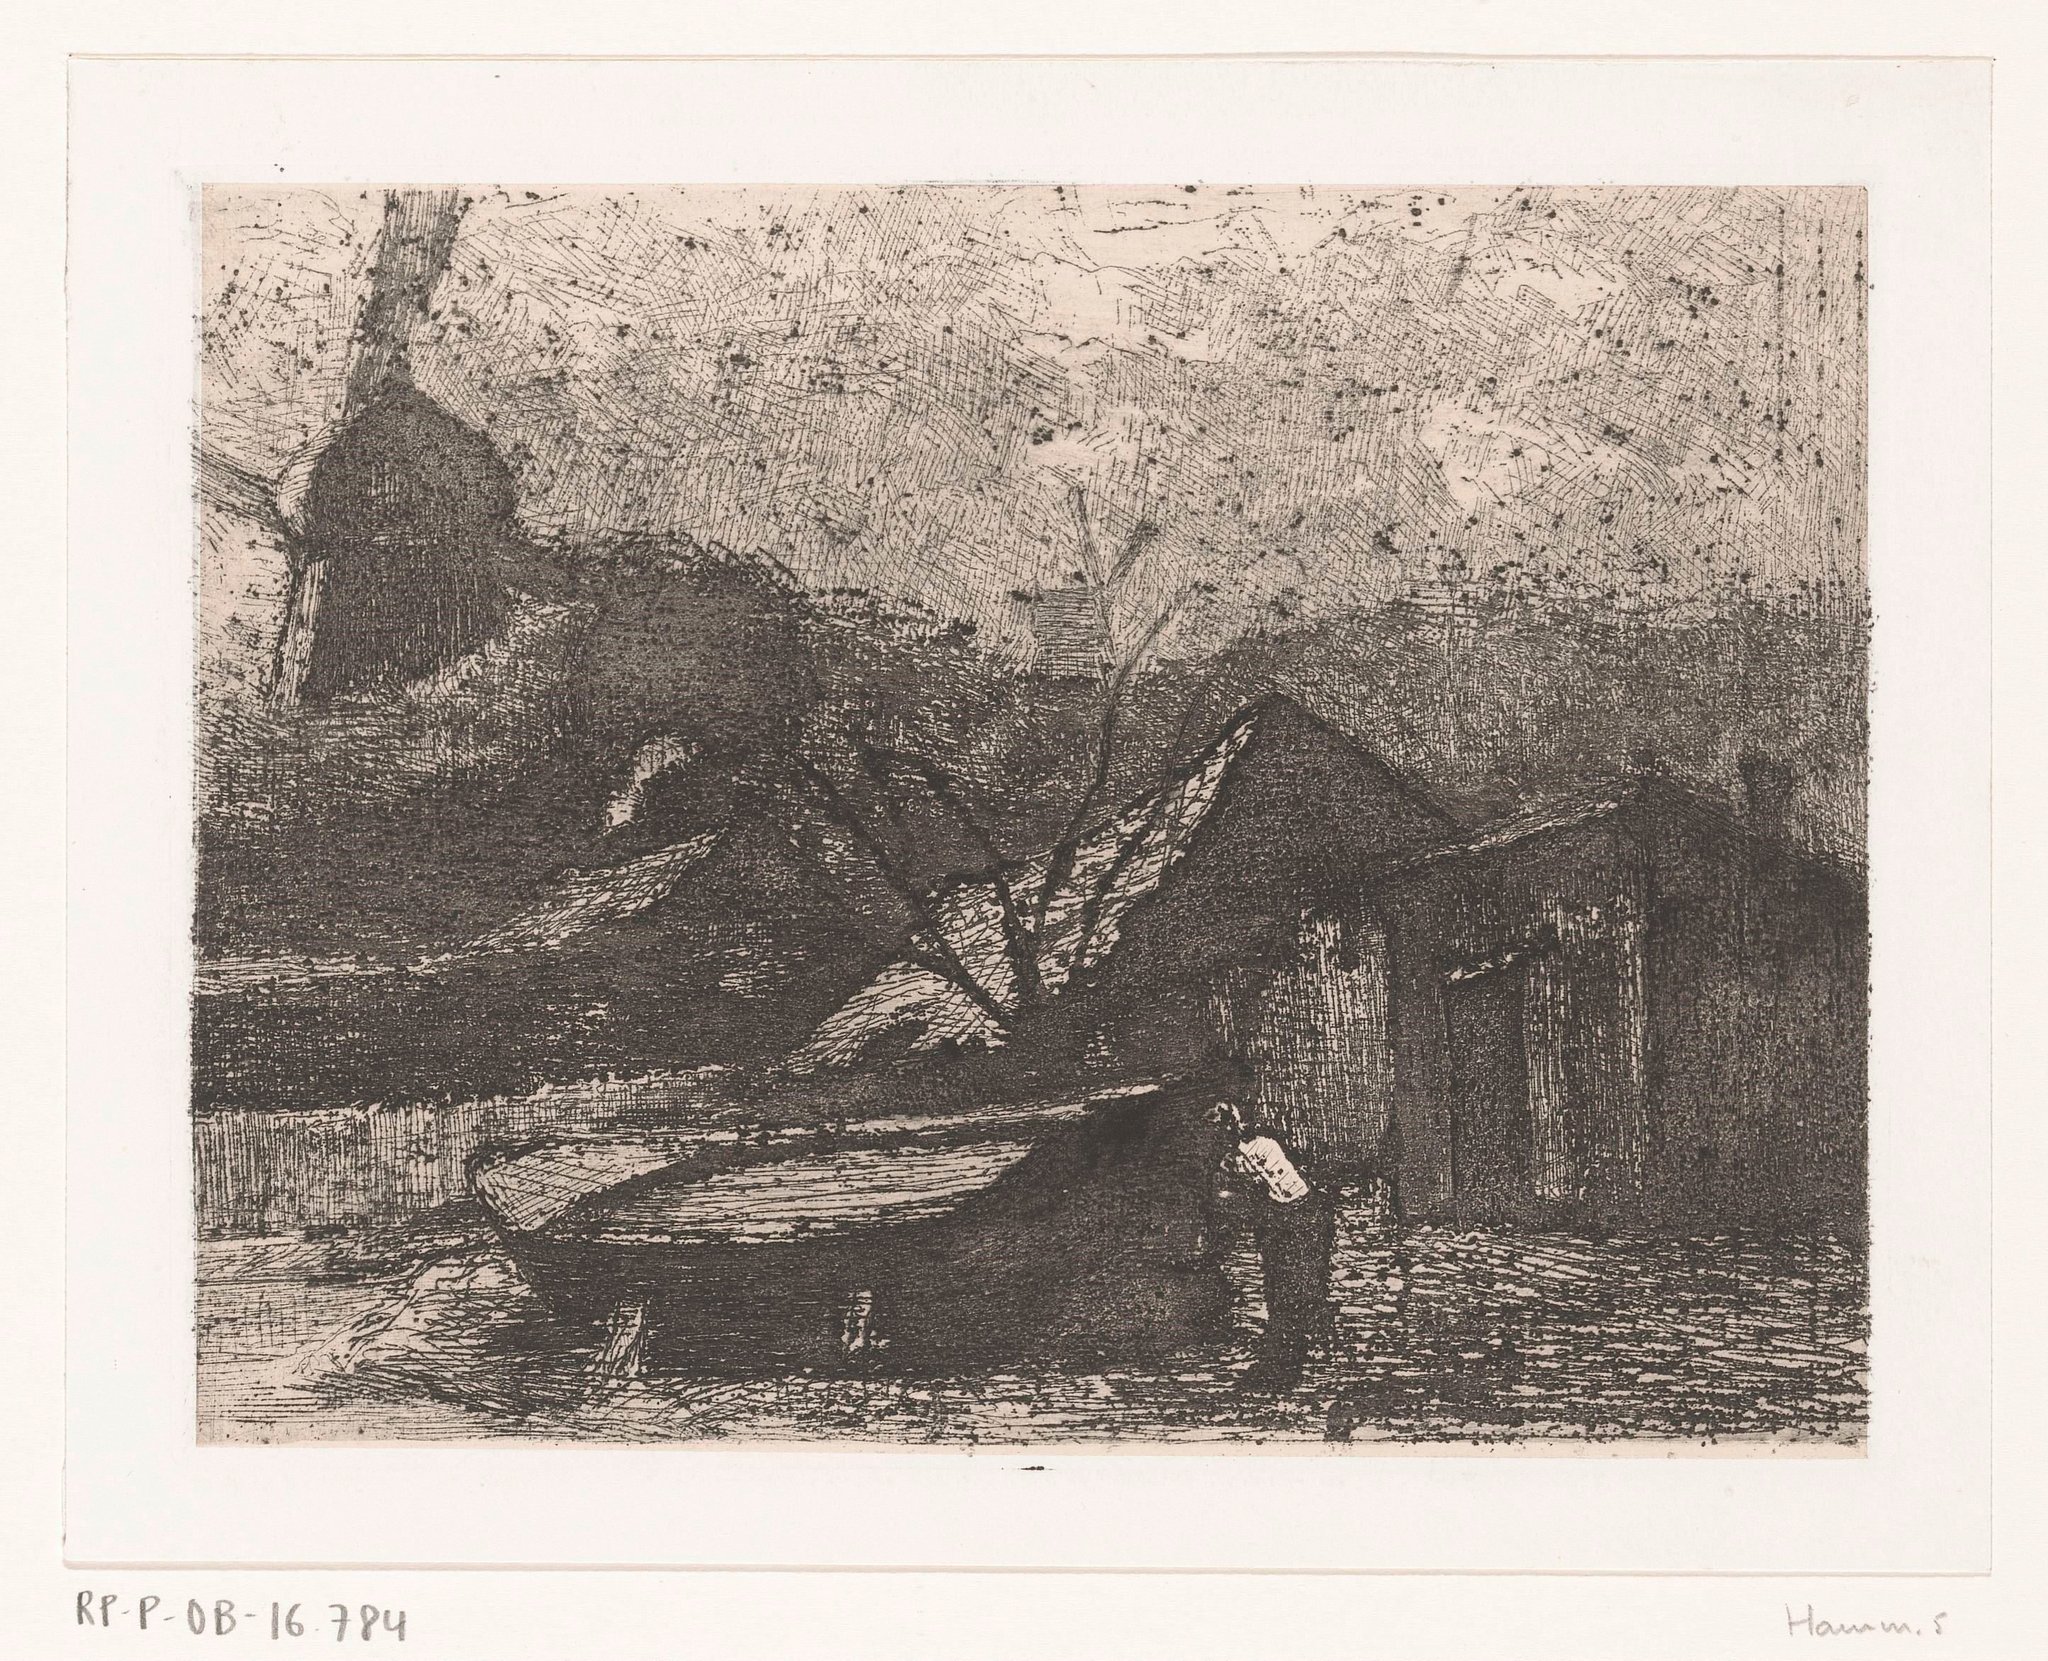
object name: print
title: Schuit op een wal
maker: eduard karsen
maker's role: draughtsman, painter, print maker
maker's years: 1860-1941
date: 1870-1941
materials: paper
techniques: etching, intaglio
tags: ships (in general), windmill in landscape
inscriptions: collector's mark: Lugt 2228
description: Prent afkomstig uit de Portefeuille der Nederlandsche Etsclub, zesde jaargang, 1891.